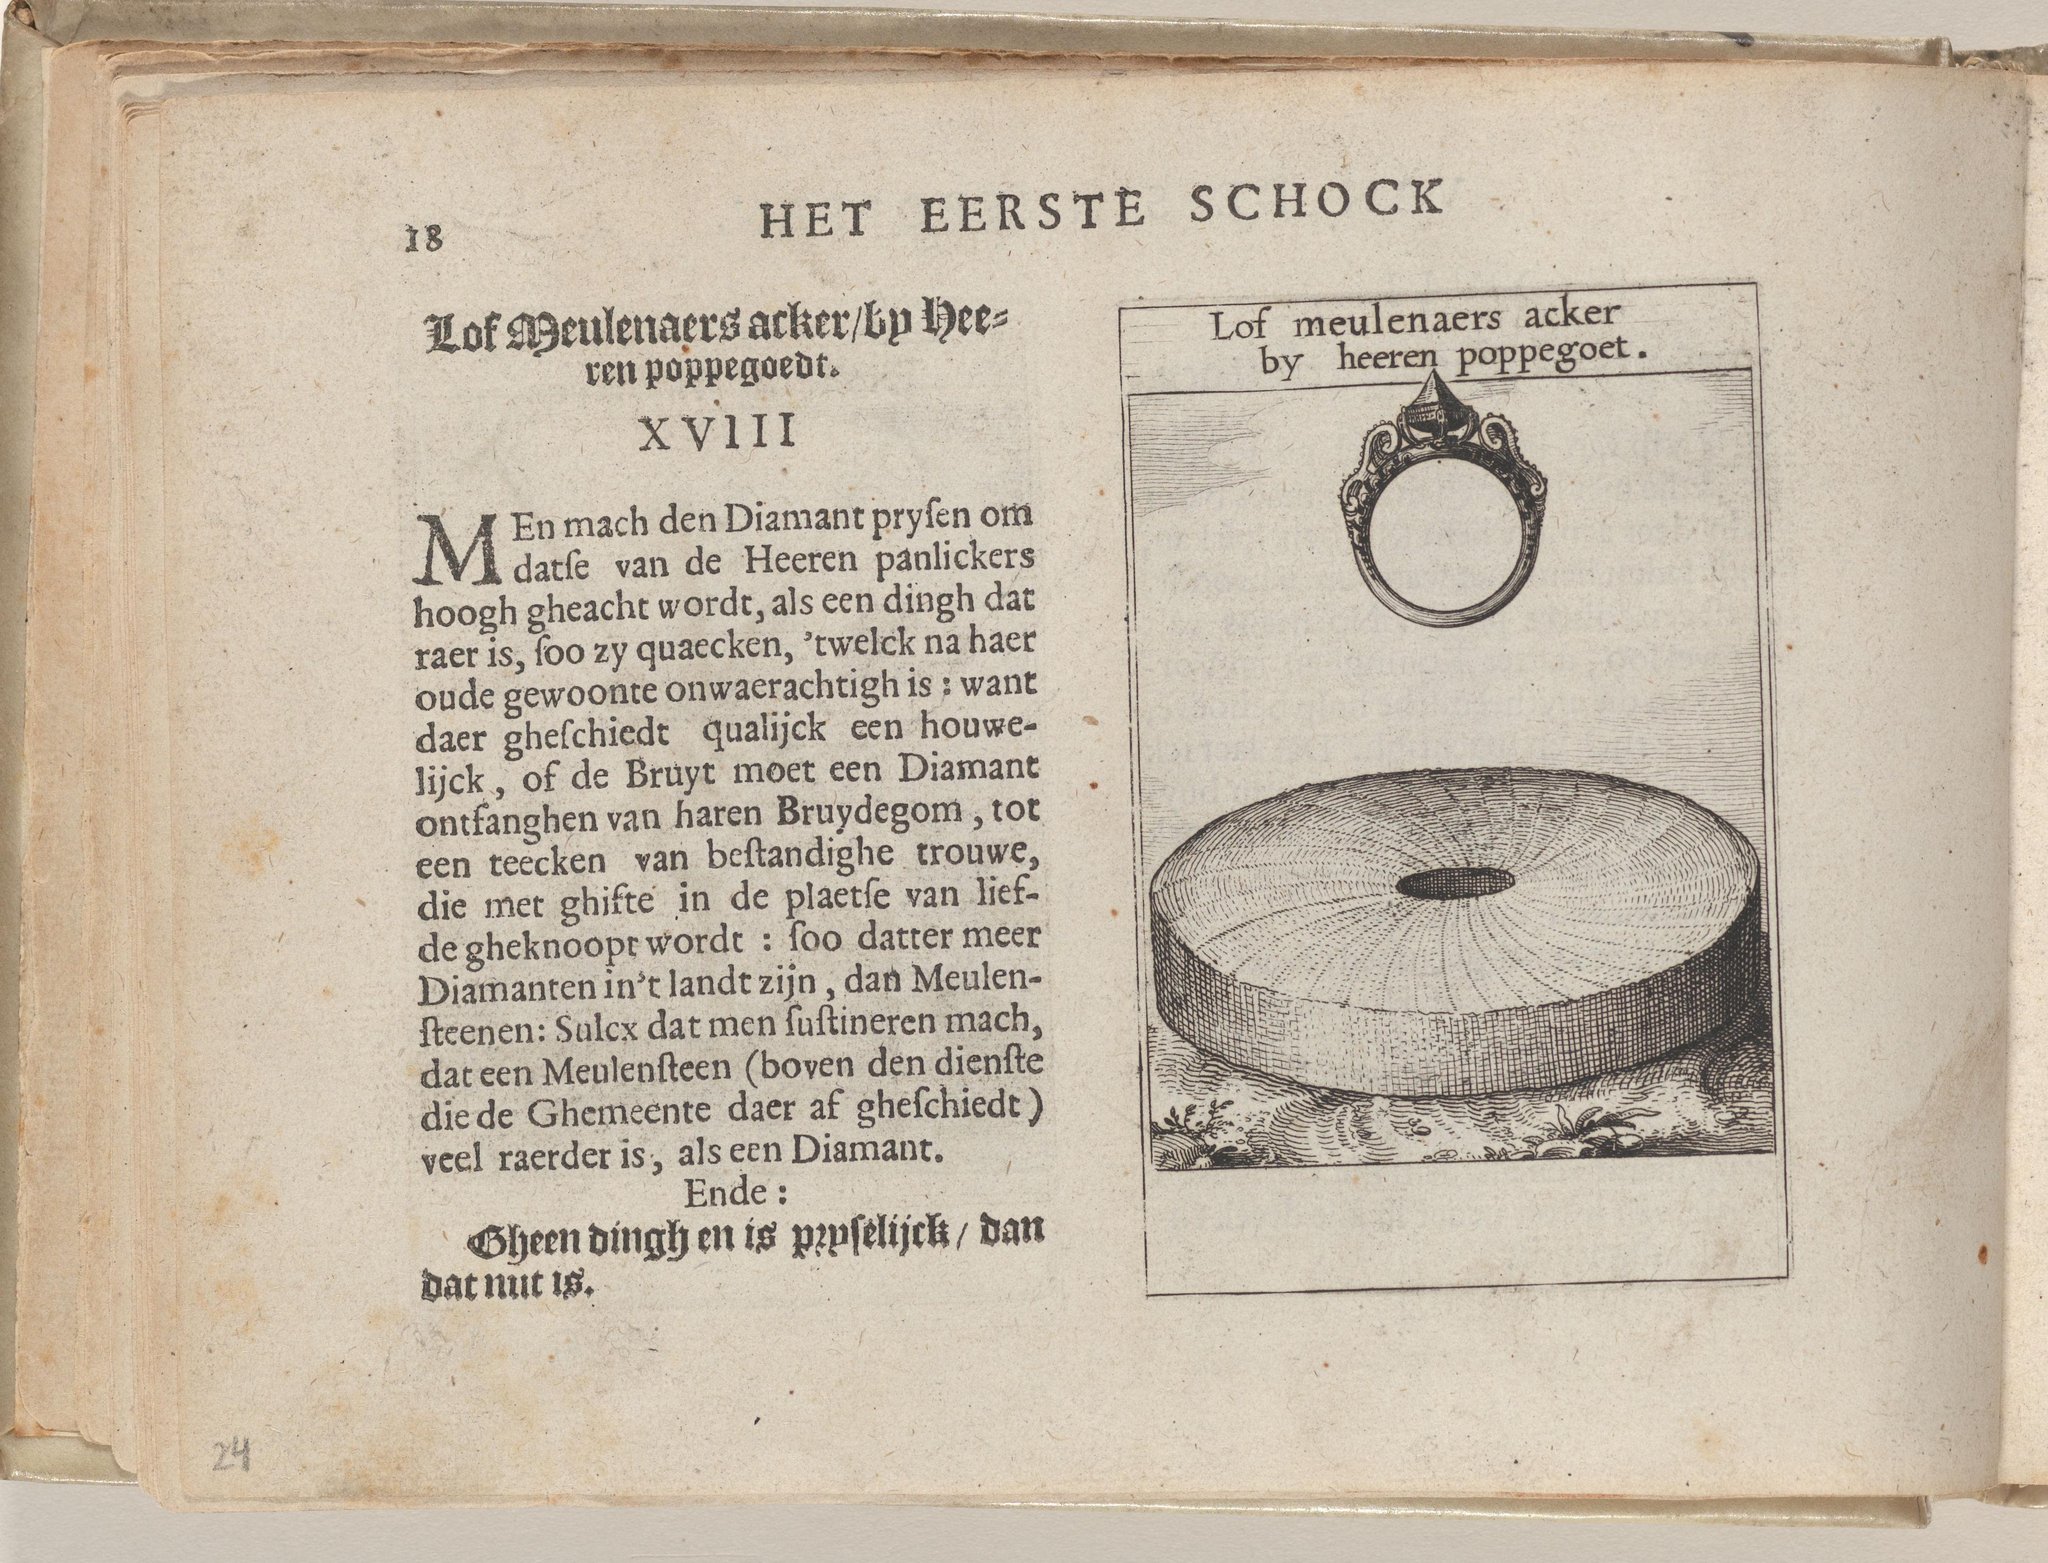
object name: album leaf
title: XVIII Lof meulenaers acker by heeren poppegoet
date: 1614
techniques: engraving, printing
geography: the hague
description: XVIII Lof meulenaers acker by heeren poppegoet. Eerste schok. Onderdeel van 'Sinnepoppen', R. Visscher, 1614.